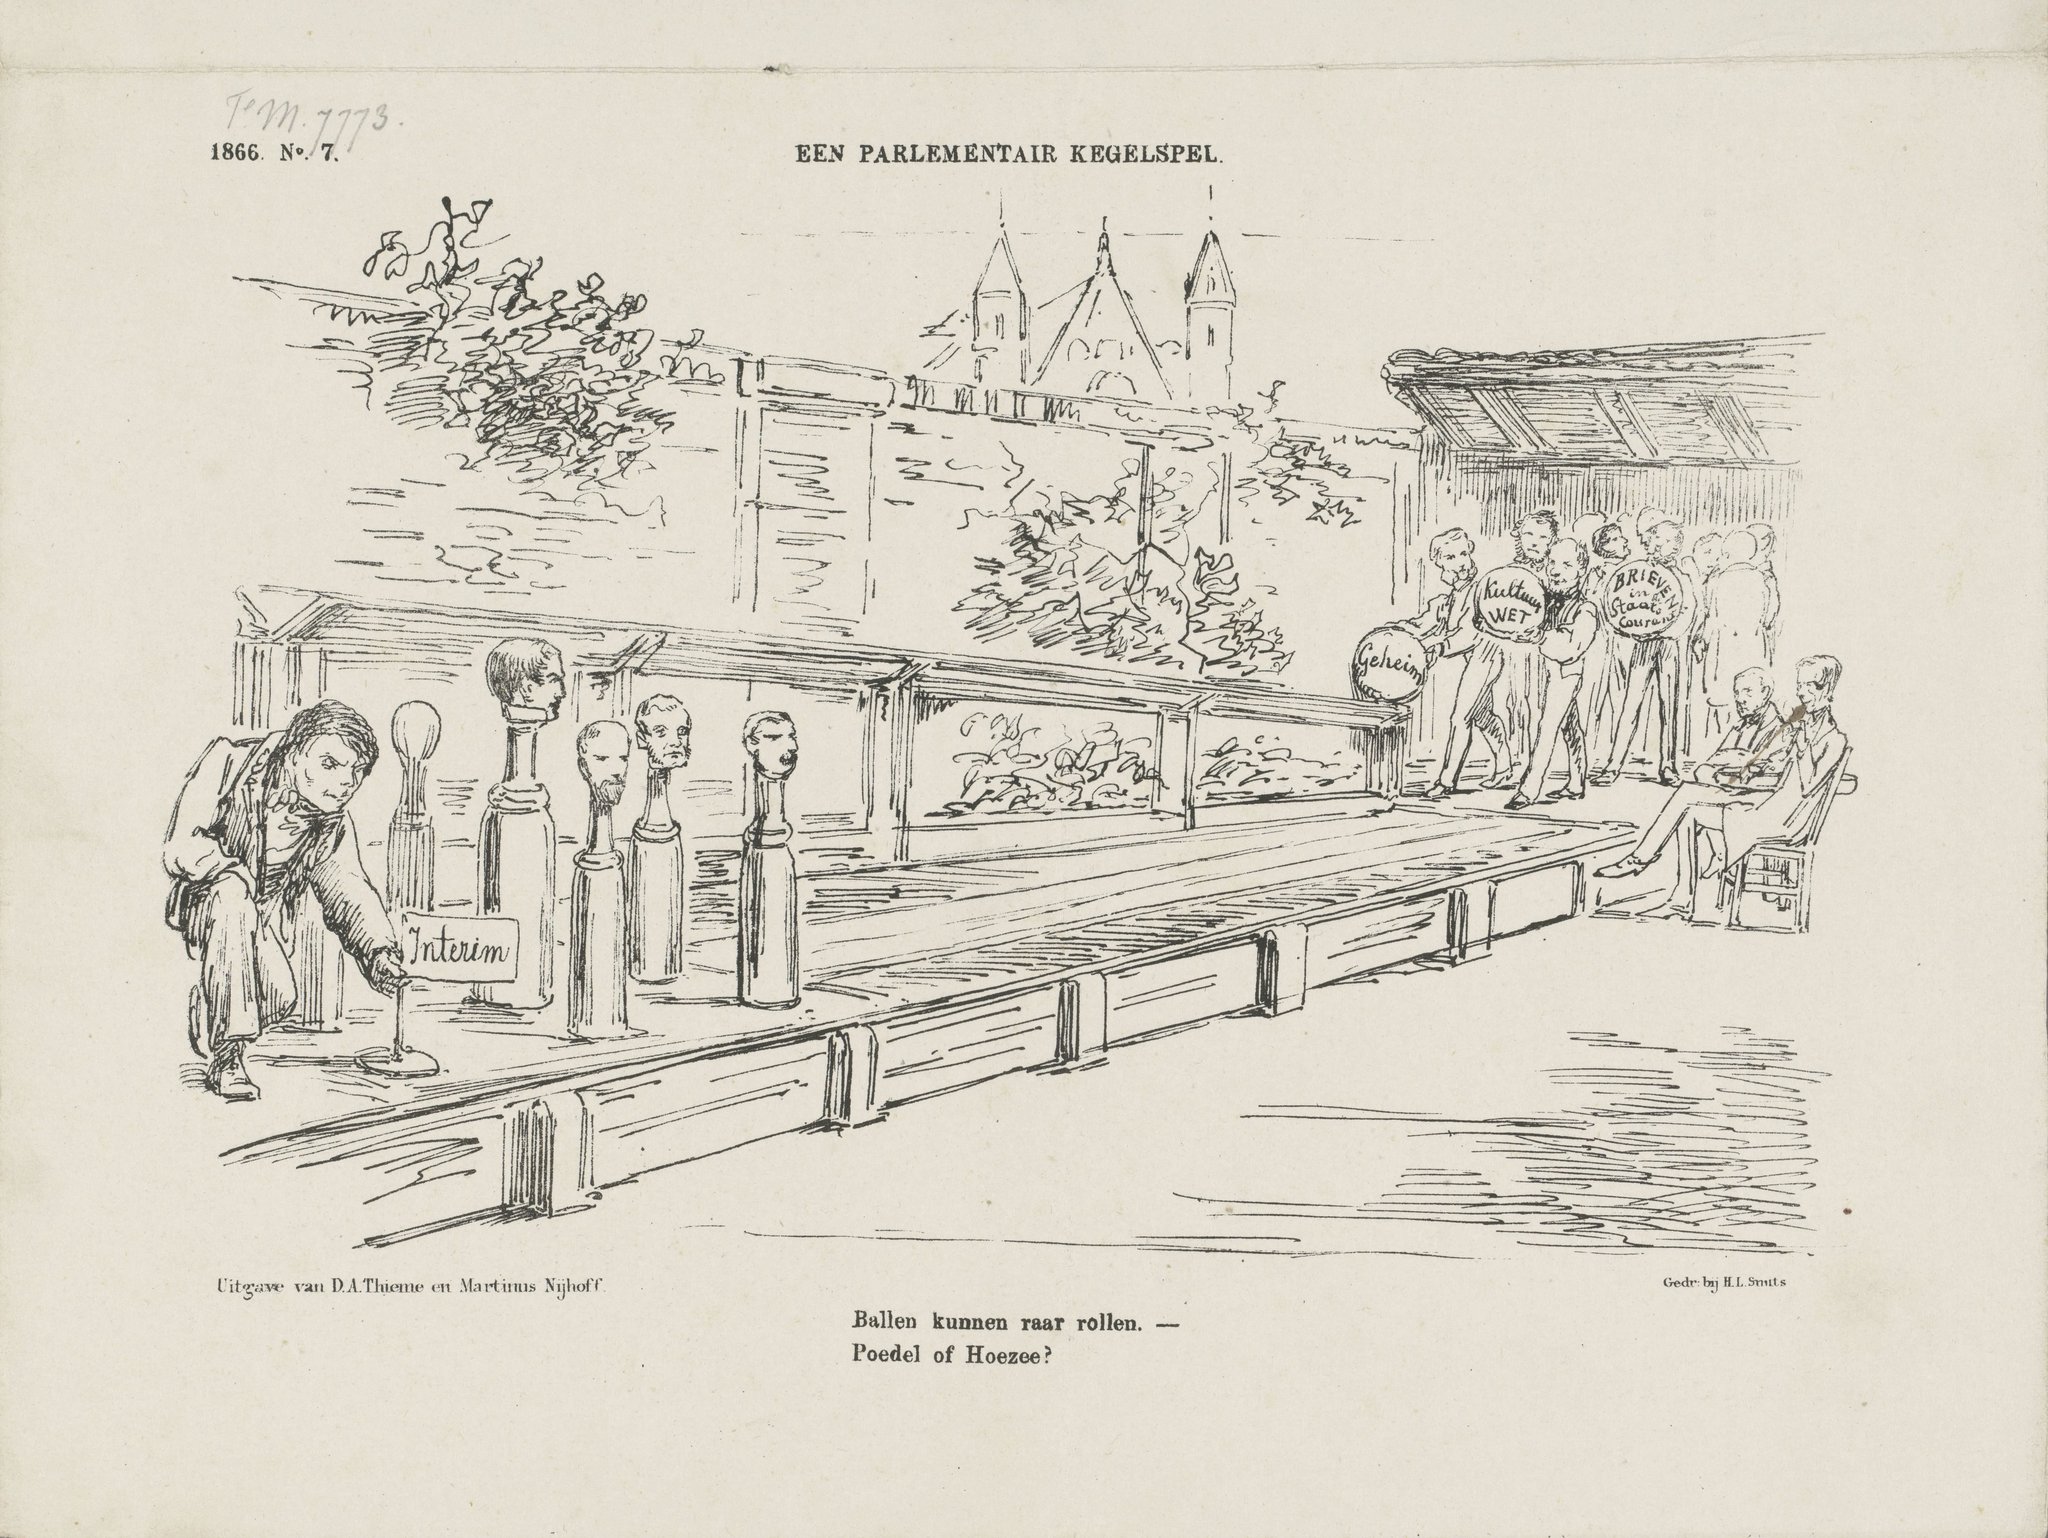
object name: print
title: Een parlementair kegelspel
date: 1866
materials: paper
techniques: lithograph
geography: netherlands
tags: johan rudolf thorbecke, guillaume groen van prinsterer, politician, bowling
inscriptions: collector's mark: Lugt 2228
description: Spotprent waarin op een kegelbaan Van Zuylen, Rochussen en Wintgens klaar staan om de kegels met de koppen van Fransen van de Putte, Van Bosse en Cremers (het ministerie a.i.), klaar gezet door Kappeyne van de Coppello, omver te gooien. Thorbecke en Groen van Prinsterer kijken vanuit stoelen toe. Plaat verschenen bij het weekblad De Nederlandsche Spectator, nr. 7, 17 februari 1866.